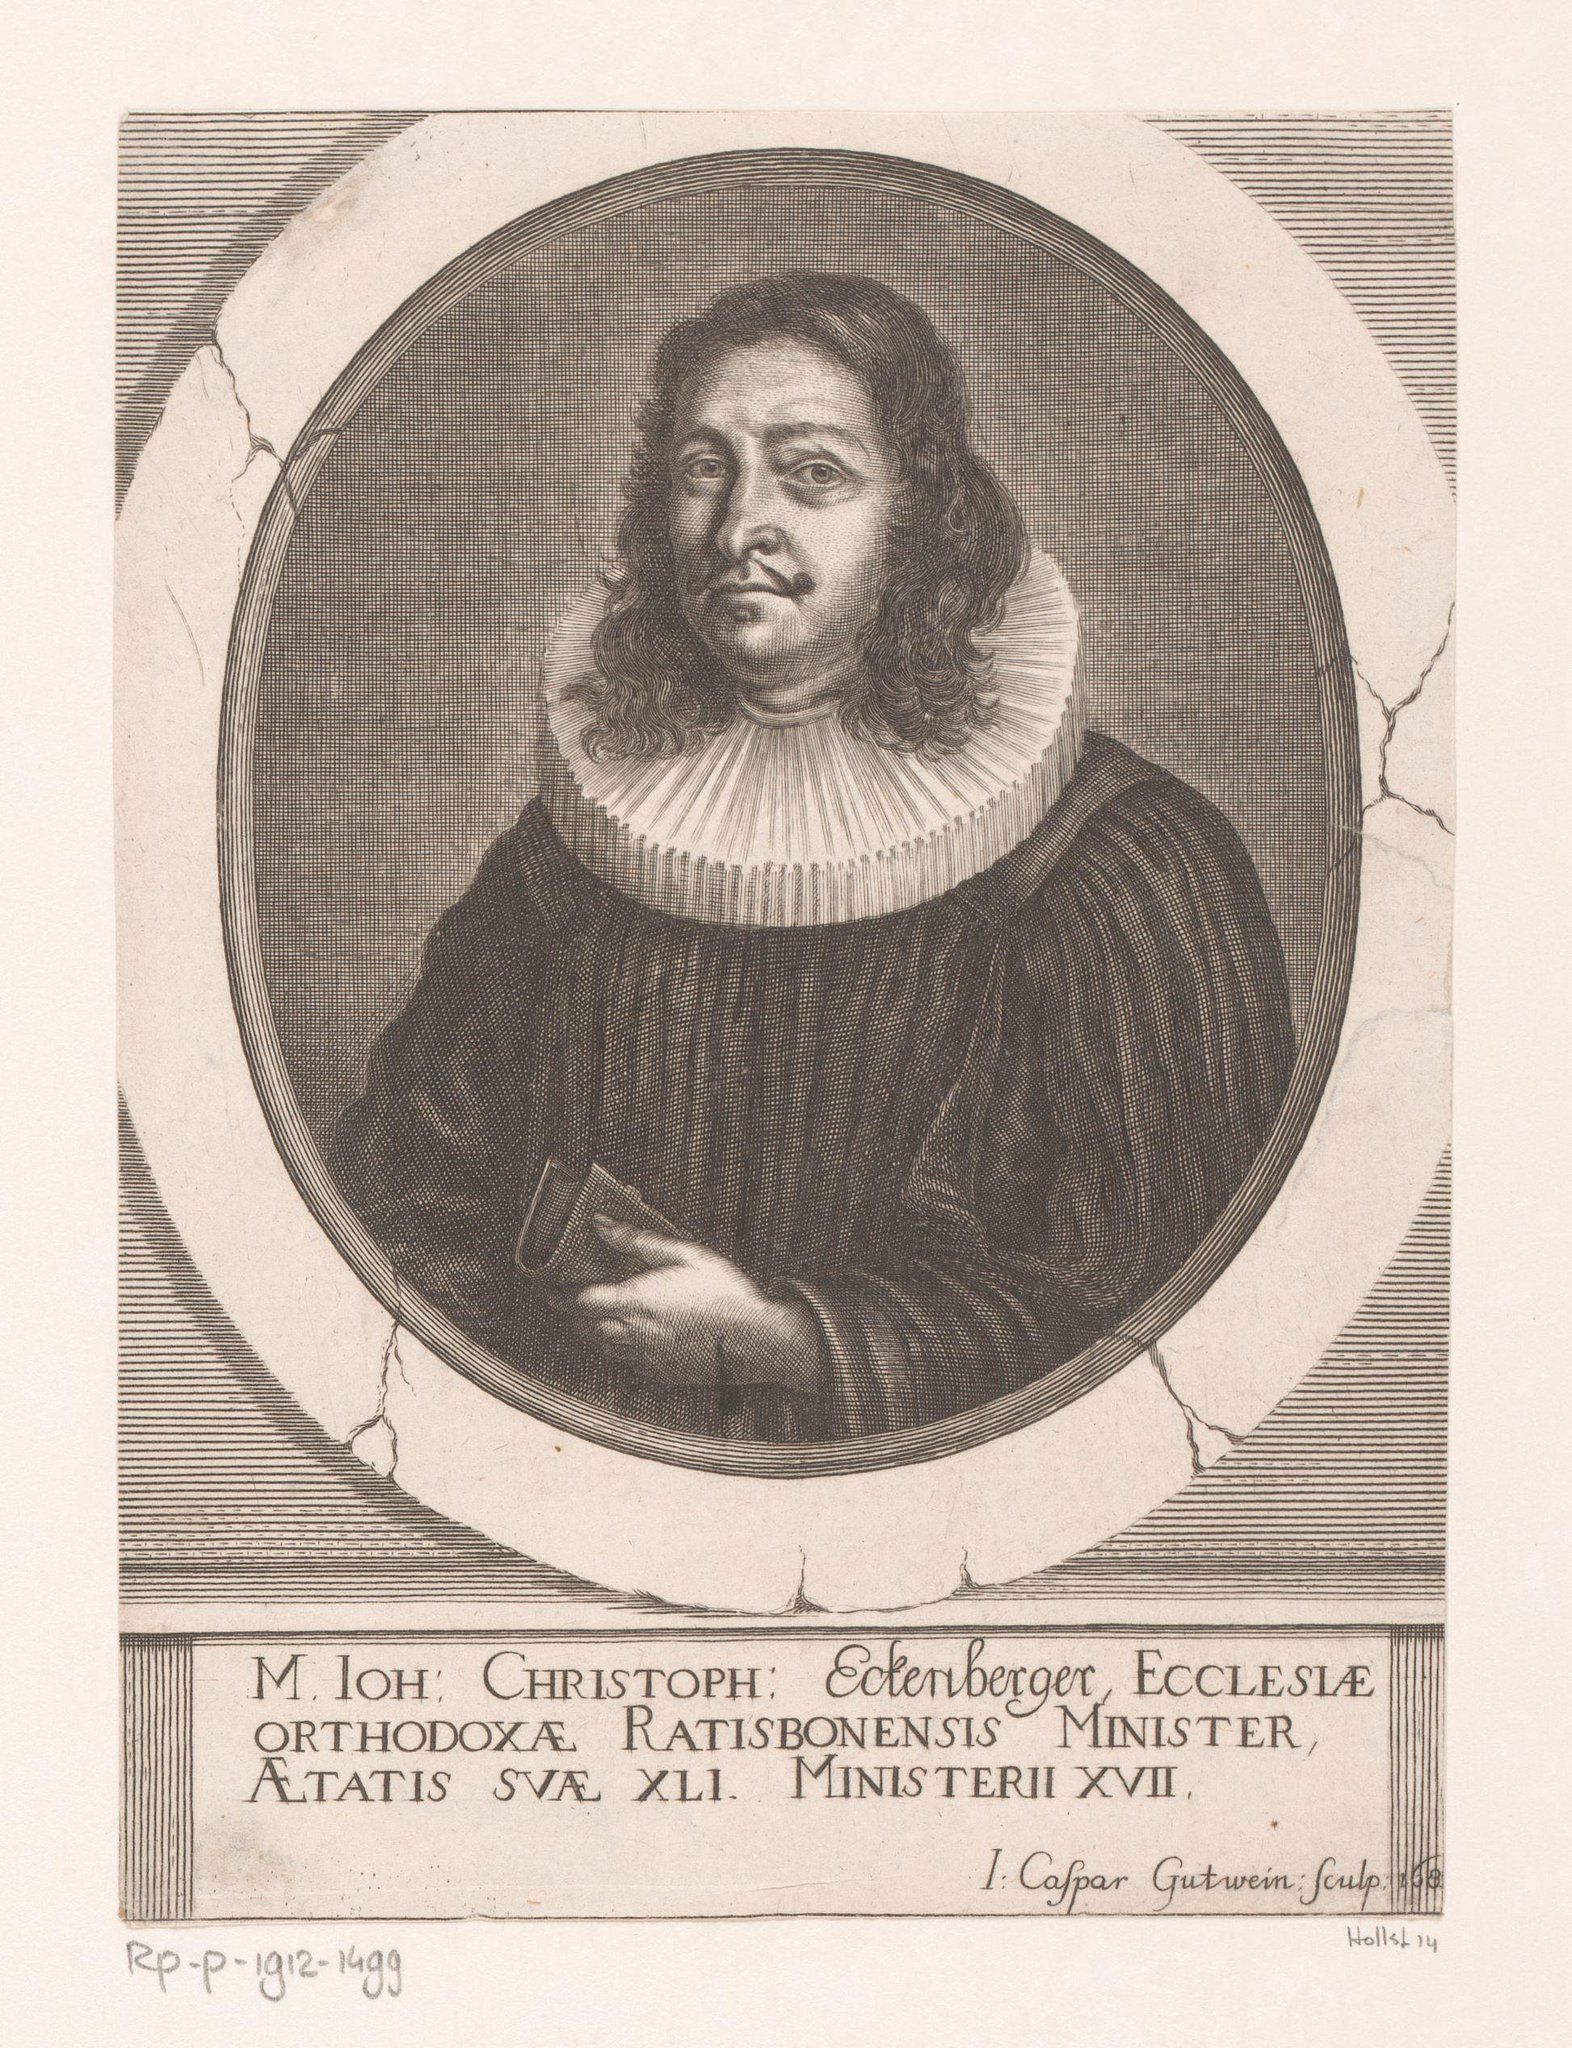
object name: print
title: Portret van Johann Christoph Eckenberger op 41-jarige leeftijd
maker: johann caspar gutwein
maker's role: print maker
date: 1685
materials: paper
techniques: engraving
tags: historical persons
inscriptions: collector's mark: Lugt 2228